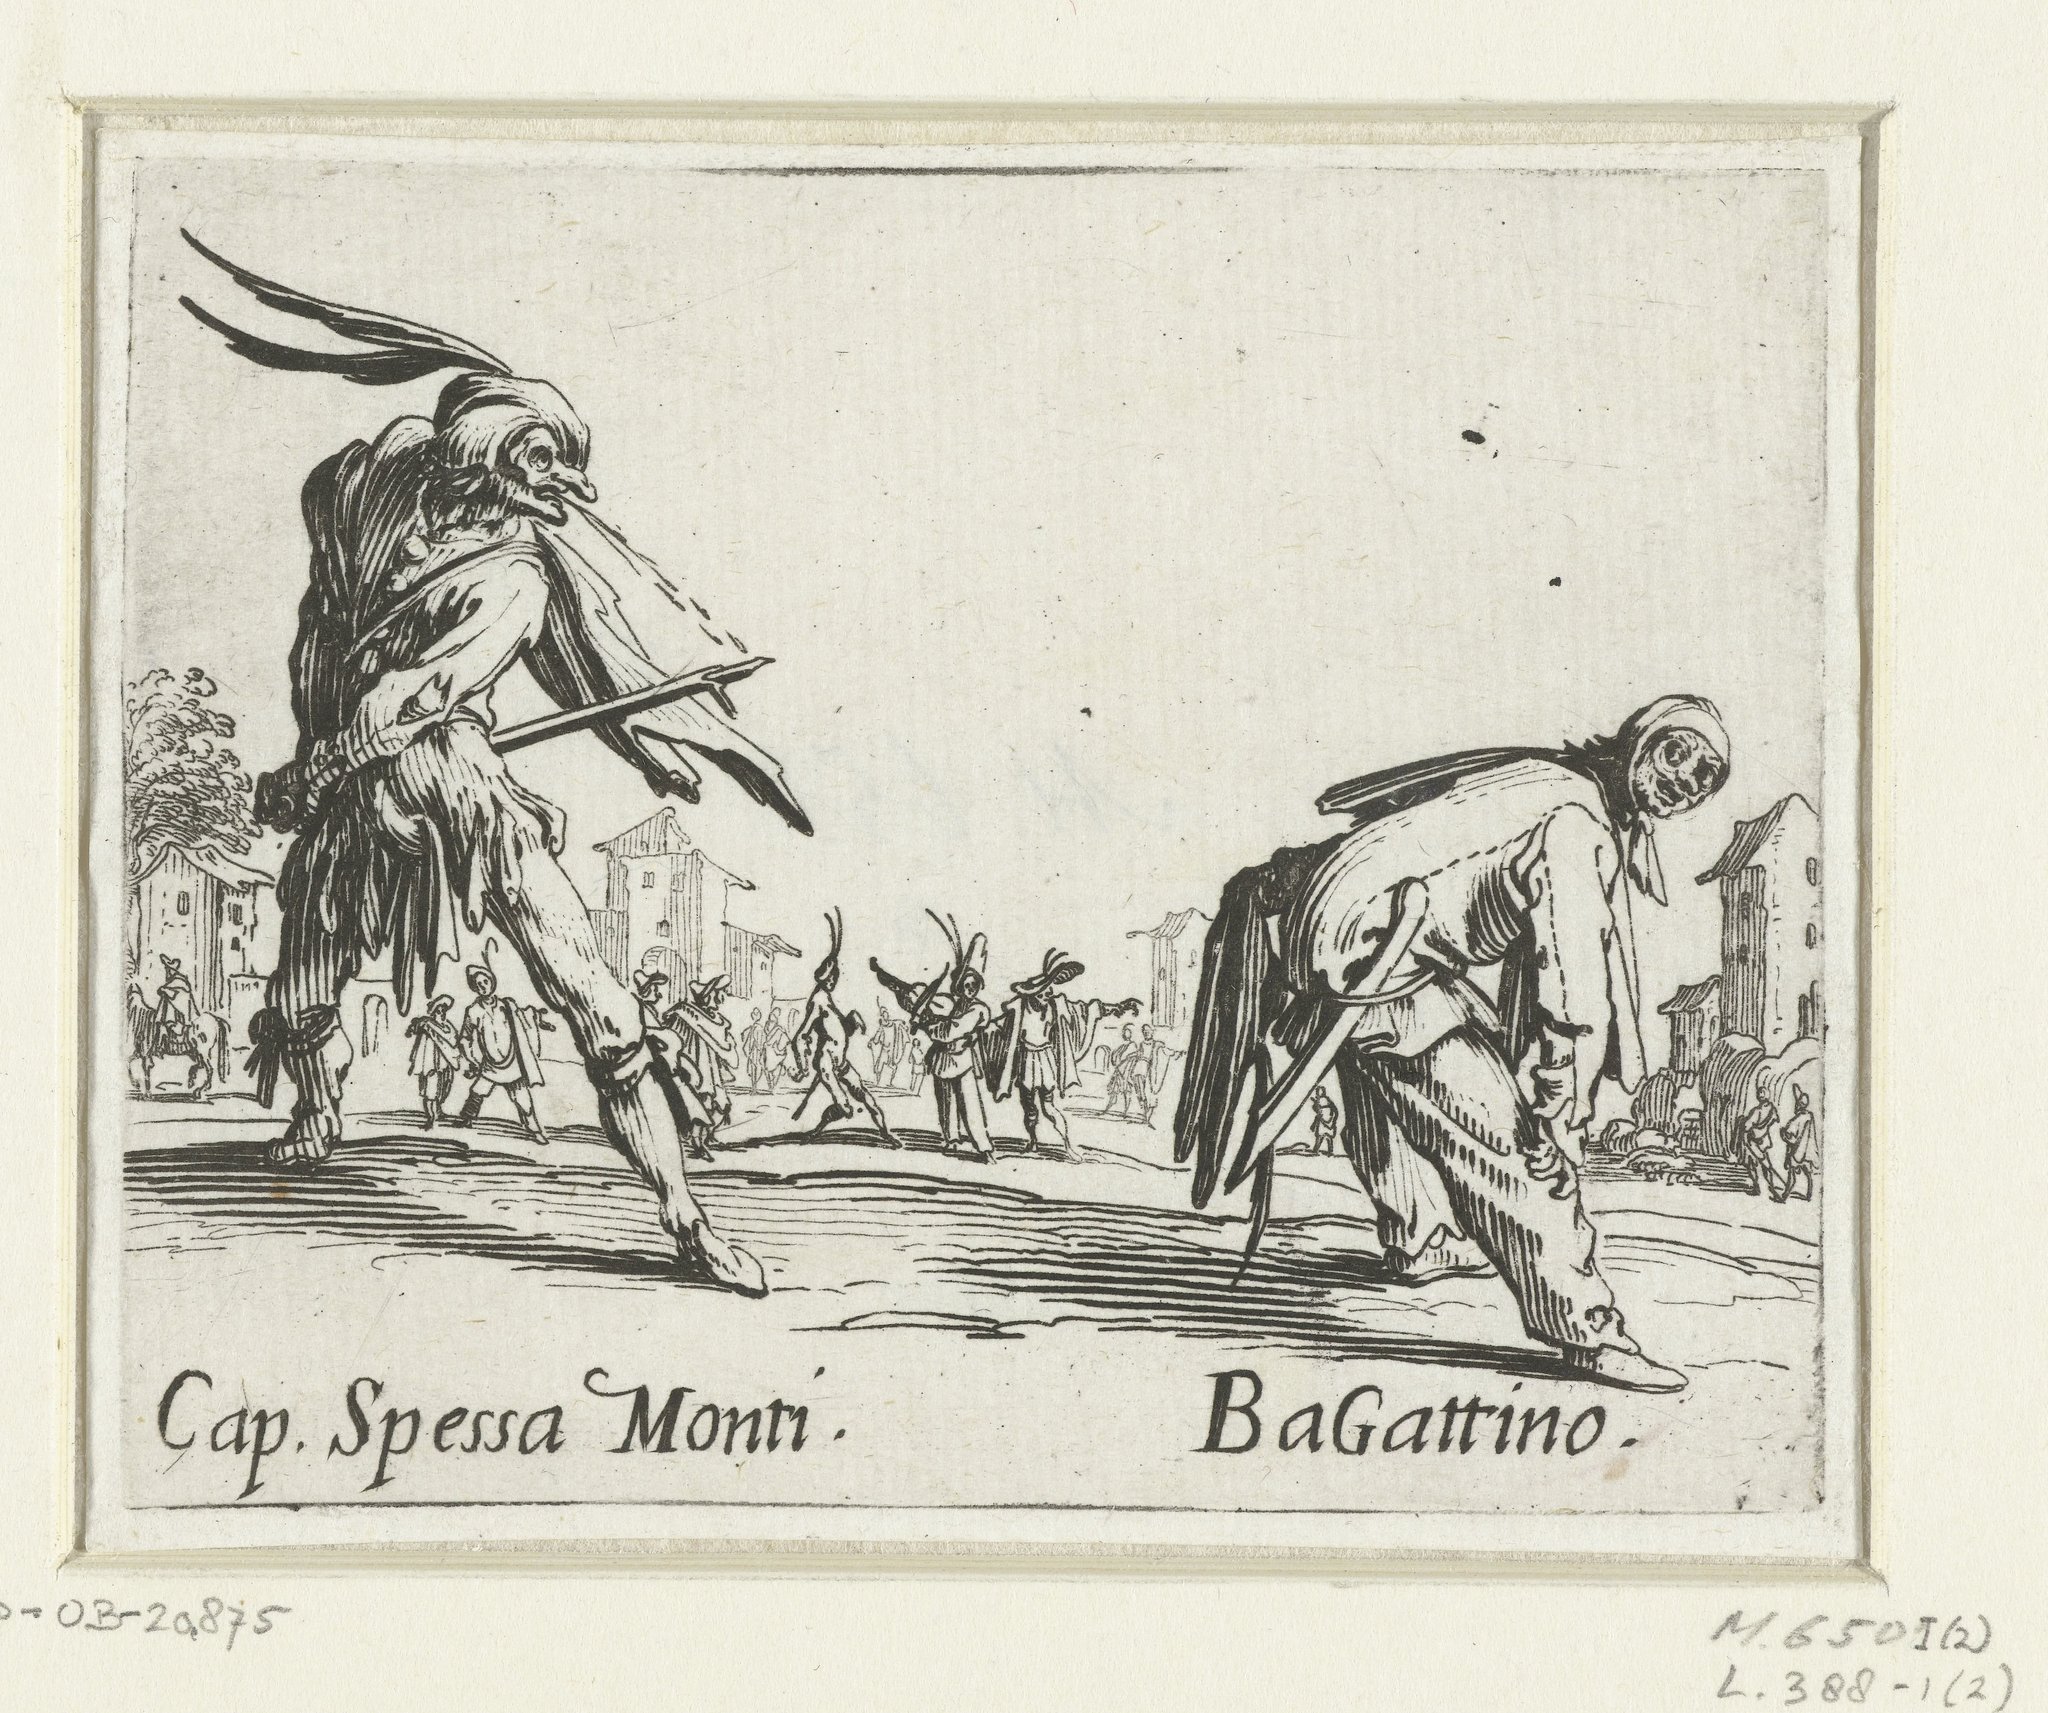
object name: print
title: Dansen van Sfessania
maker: jacques callot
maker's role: draughtsman, print maker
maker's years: 1592-1635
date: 1621-1622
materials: paper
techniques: etching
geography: nancy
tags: types in 'commedia dell'arte'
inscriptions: collector's mark: Lugt 240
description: Twee artiesten, een van hen met een gevederd hoofddeksel op, staan met de rug naar elkaar toe. De een spuugt over zijn schouder naar de ander, die gebukt staat. Onder de figuren staan hun namen genoteerd. Deze prent is onderdeel van een serie van 23 prenten (24 incl. titelprent) met telkens op de voorgrond twee straatartiesten verkleed als figuren uit de Italiaanse commedia dell'arte, en op de achtergrond toeschouwers die in de buitenlucht een (dans)voorstelling van straatartiesten gadeslaan.